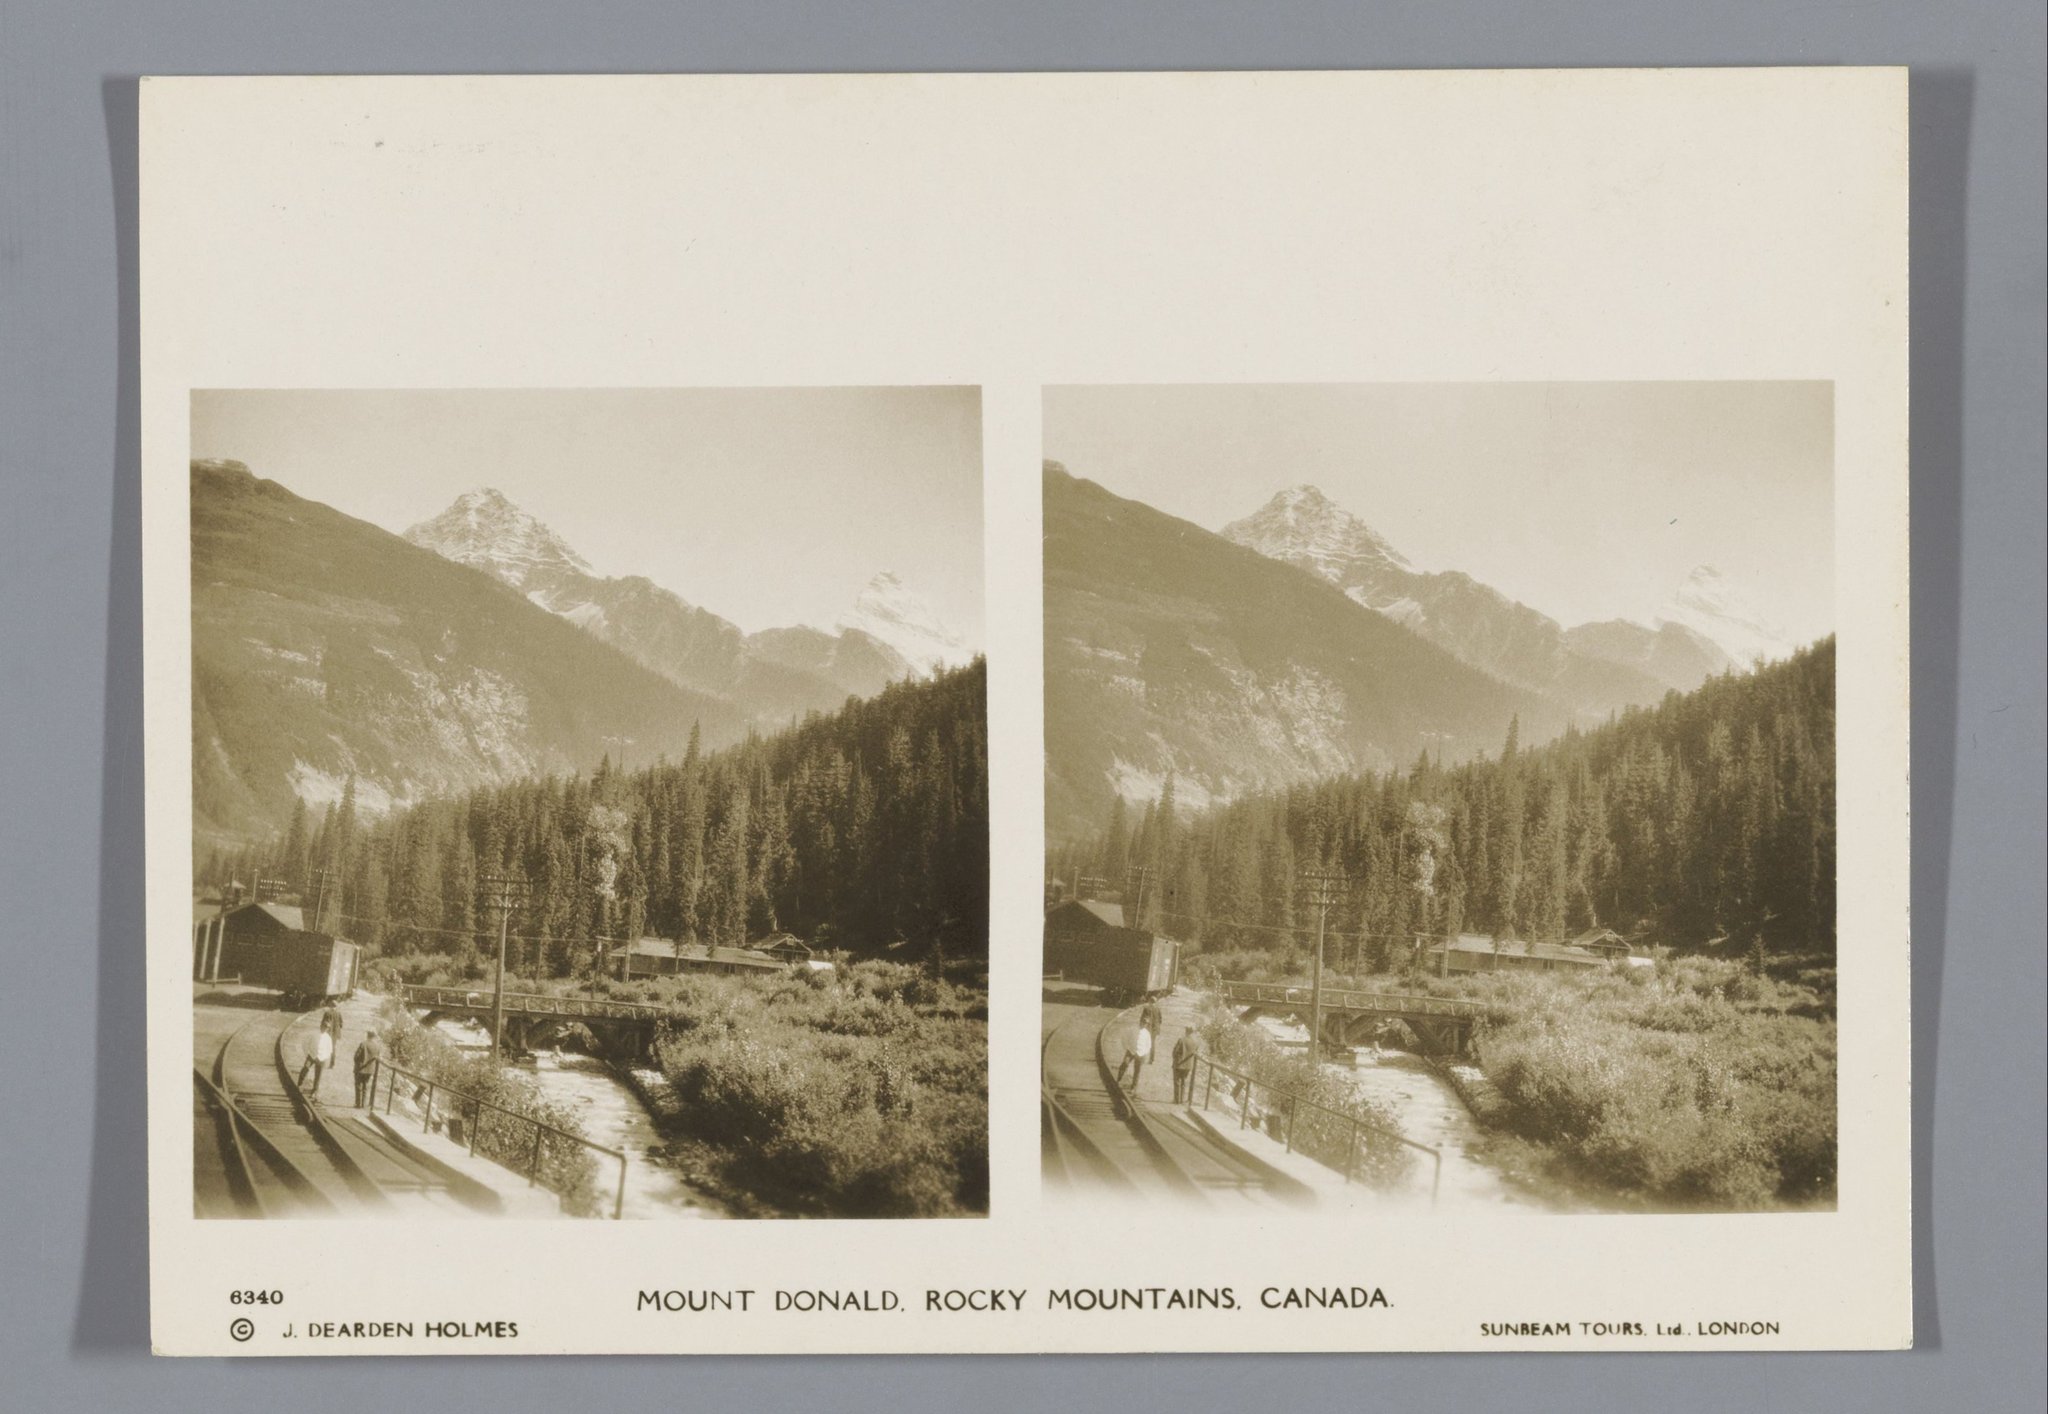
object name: stereograph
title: Mount Donald, Rocky Mountains, Canada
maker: james dearden holmes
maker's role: fotograaf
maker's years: 1873-1937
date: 1924-1926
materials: paper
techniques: gelatin silver print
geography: rocky mountains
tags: mountains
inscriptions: number: ‘6340’